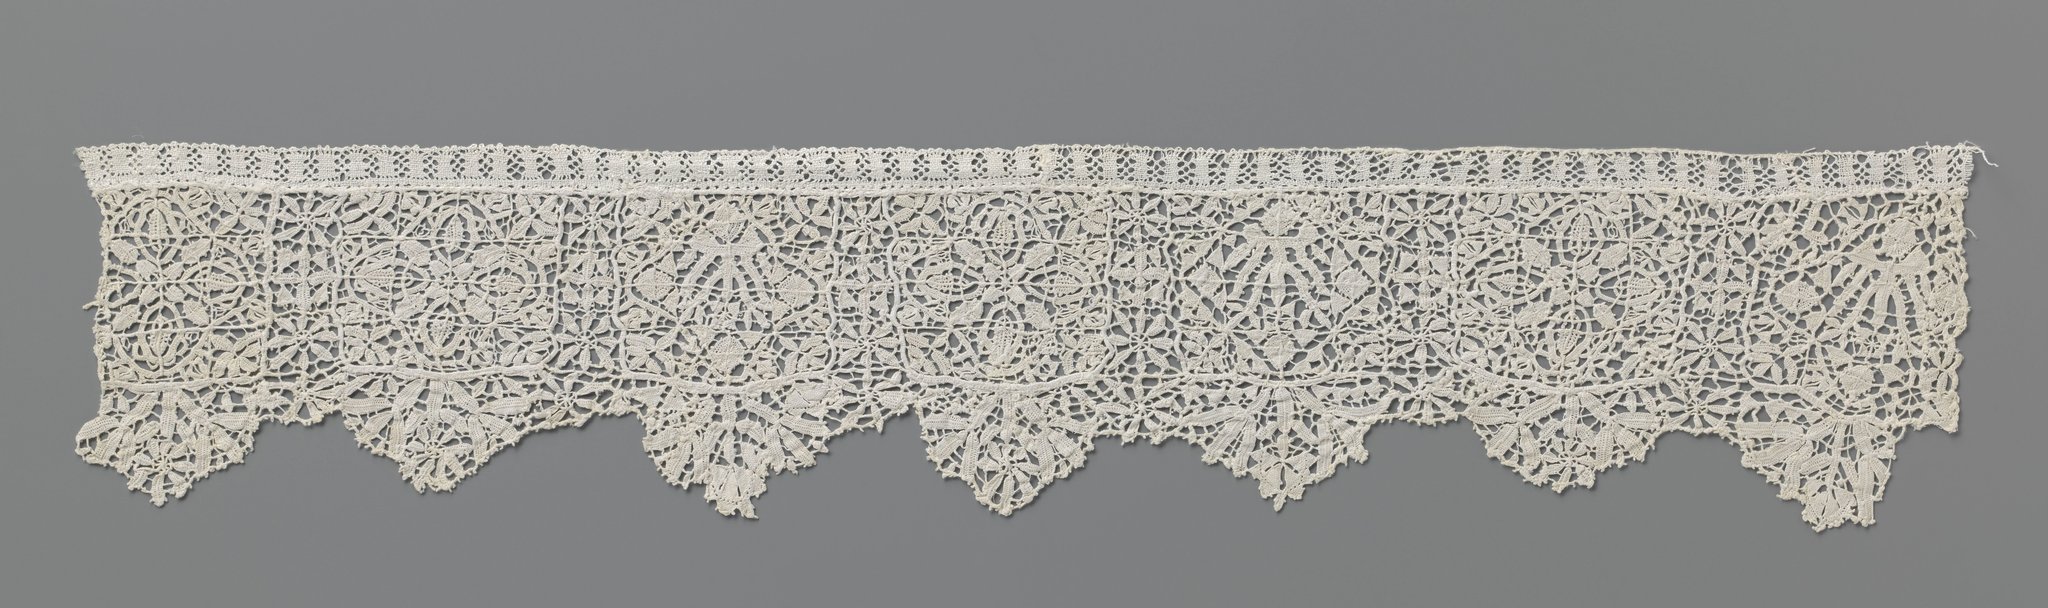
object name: strip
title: Strook naaldkant met afwisselend een rozet en een ruit in geometrisch verdeelde vlakken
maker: Anonymous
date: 1630-1640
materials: linen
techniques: needle lace, punto in aria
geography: england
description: Strook naturelkleurige naaldkant: punto in aria. Het patroon bestaat afwisselend uit een rozet en een ruit in een vierkant die is opgebouwd uit zestien kleine vierkantjes. Tussen de grote vierkanten in staat steeds een kolom van drie vierkantjes met in elk een rozet. Onder elk groot vierkant hangt een drielobbige schulp, die ter hoogte van de kolom met rozetjes met elkaar wordt verbonden door een vierde rozet. De bovenzijde is afgewerkt met een geklost bandje. De schulpenrand is afgewerkt met picots.